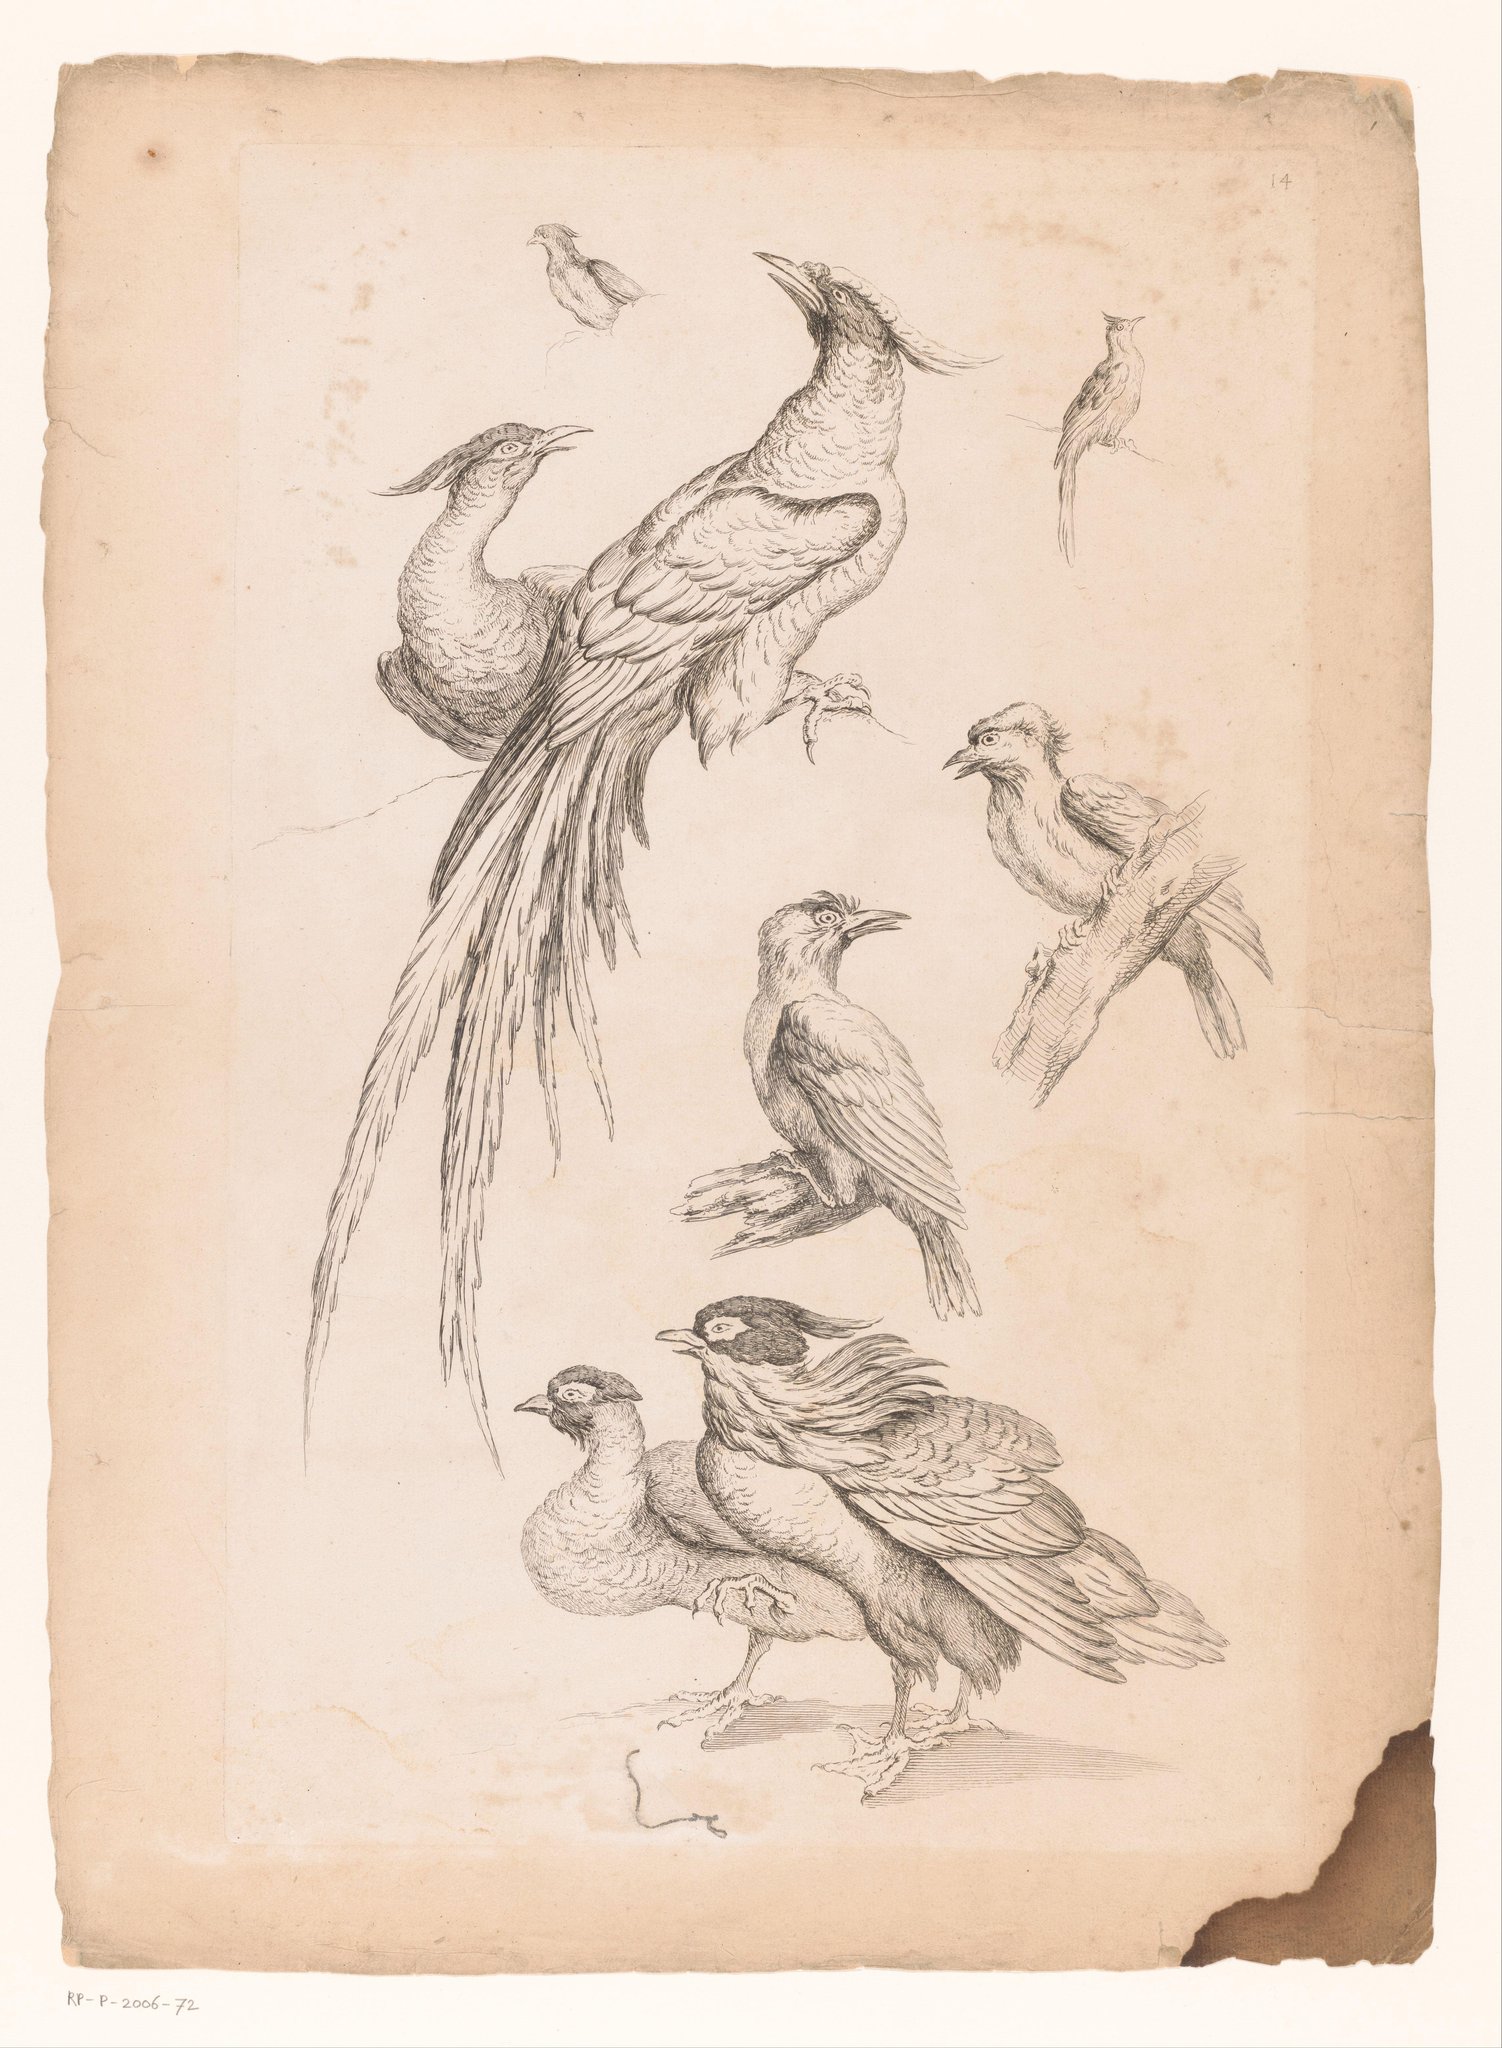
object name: print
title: Verschillende Chinese vogels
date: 1742-1750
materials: paper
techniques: etching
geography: paris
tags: birds, ornamental birds: bird of paradise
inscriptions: collector's mark: Lugt 2760, collector's mark: Lugt 2228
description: Maakt deel uit van een vijftiendelige serie met prenten van vogels uit China.